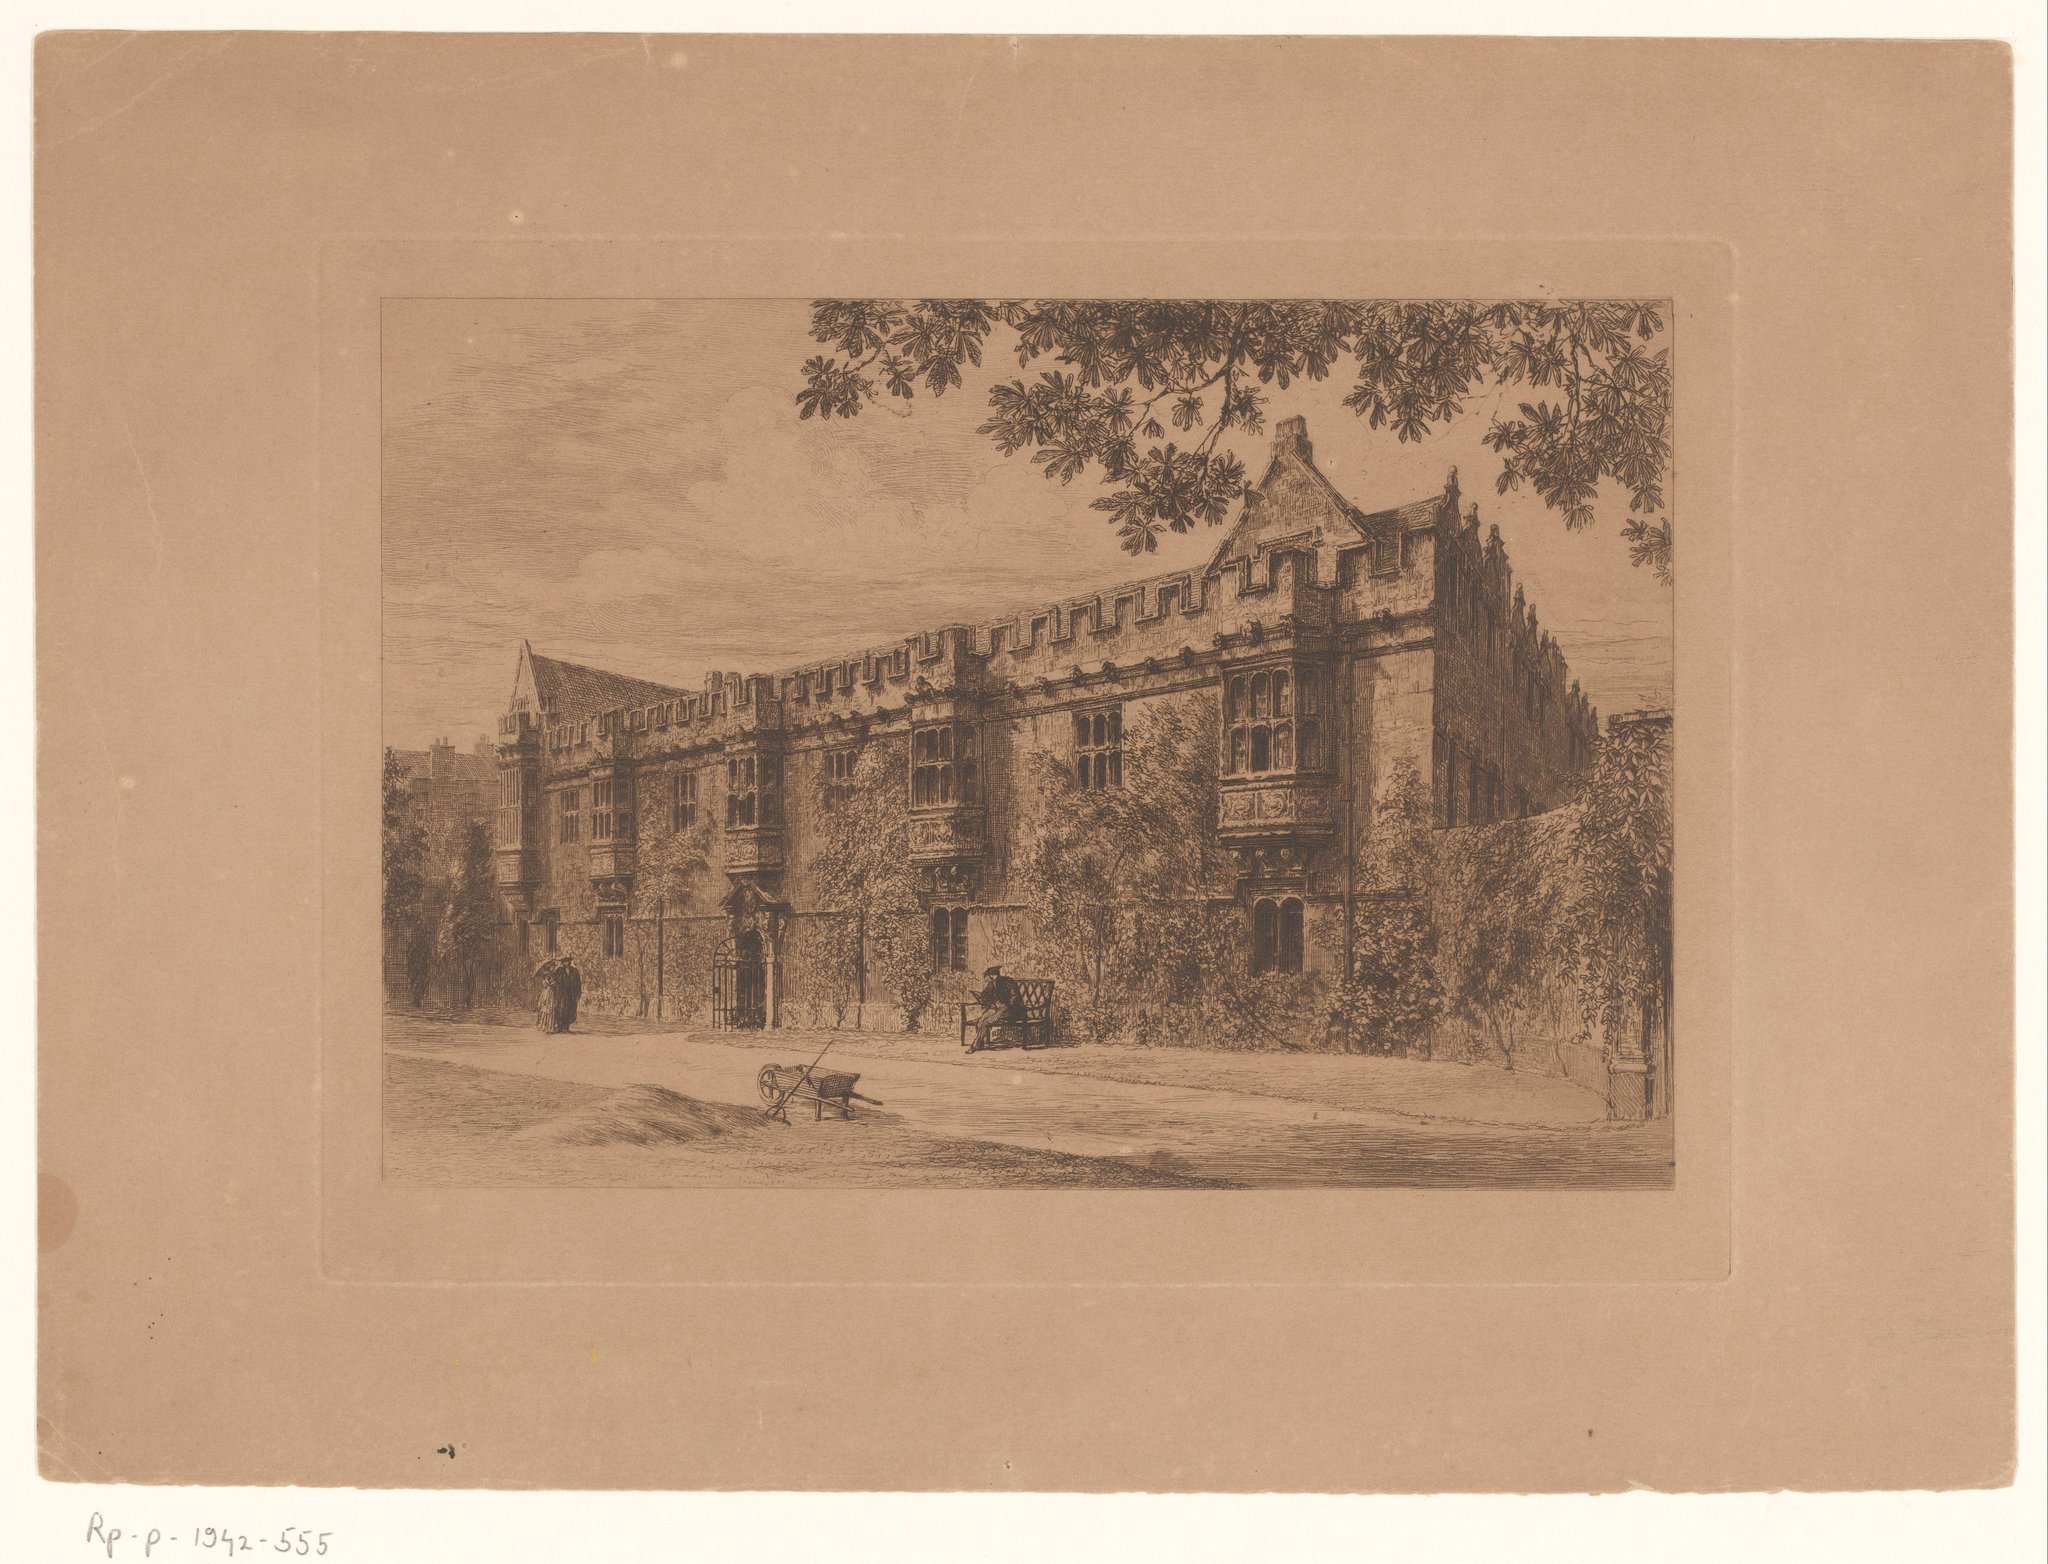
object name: print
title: Gezicht op St. John's College, te Oxford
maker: Anonymous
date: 1750-1849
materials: paper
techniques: etching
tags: university building, college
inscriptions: collector's mark: Lugt 2228